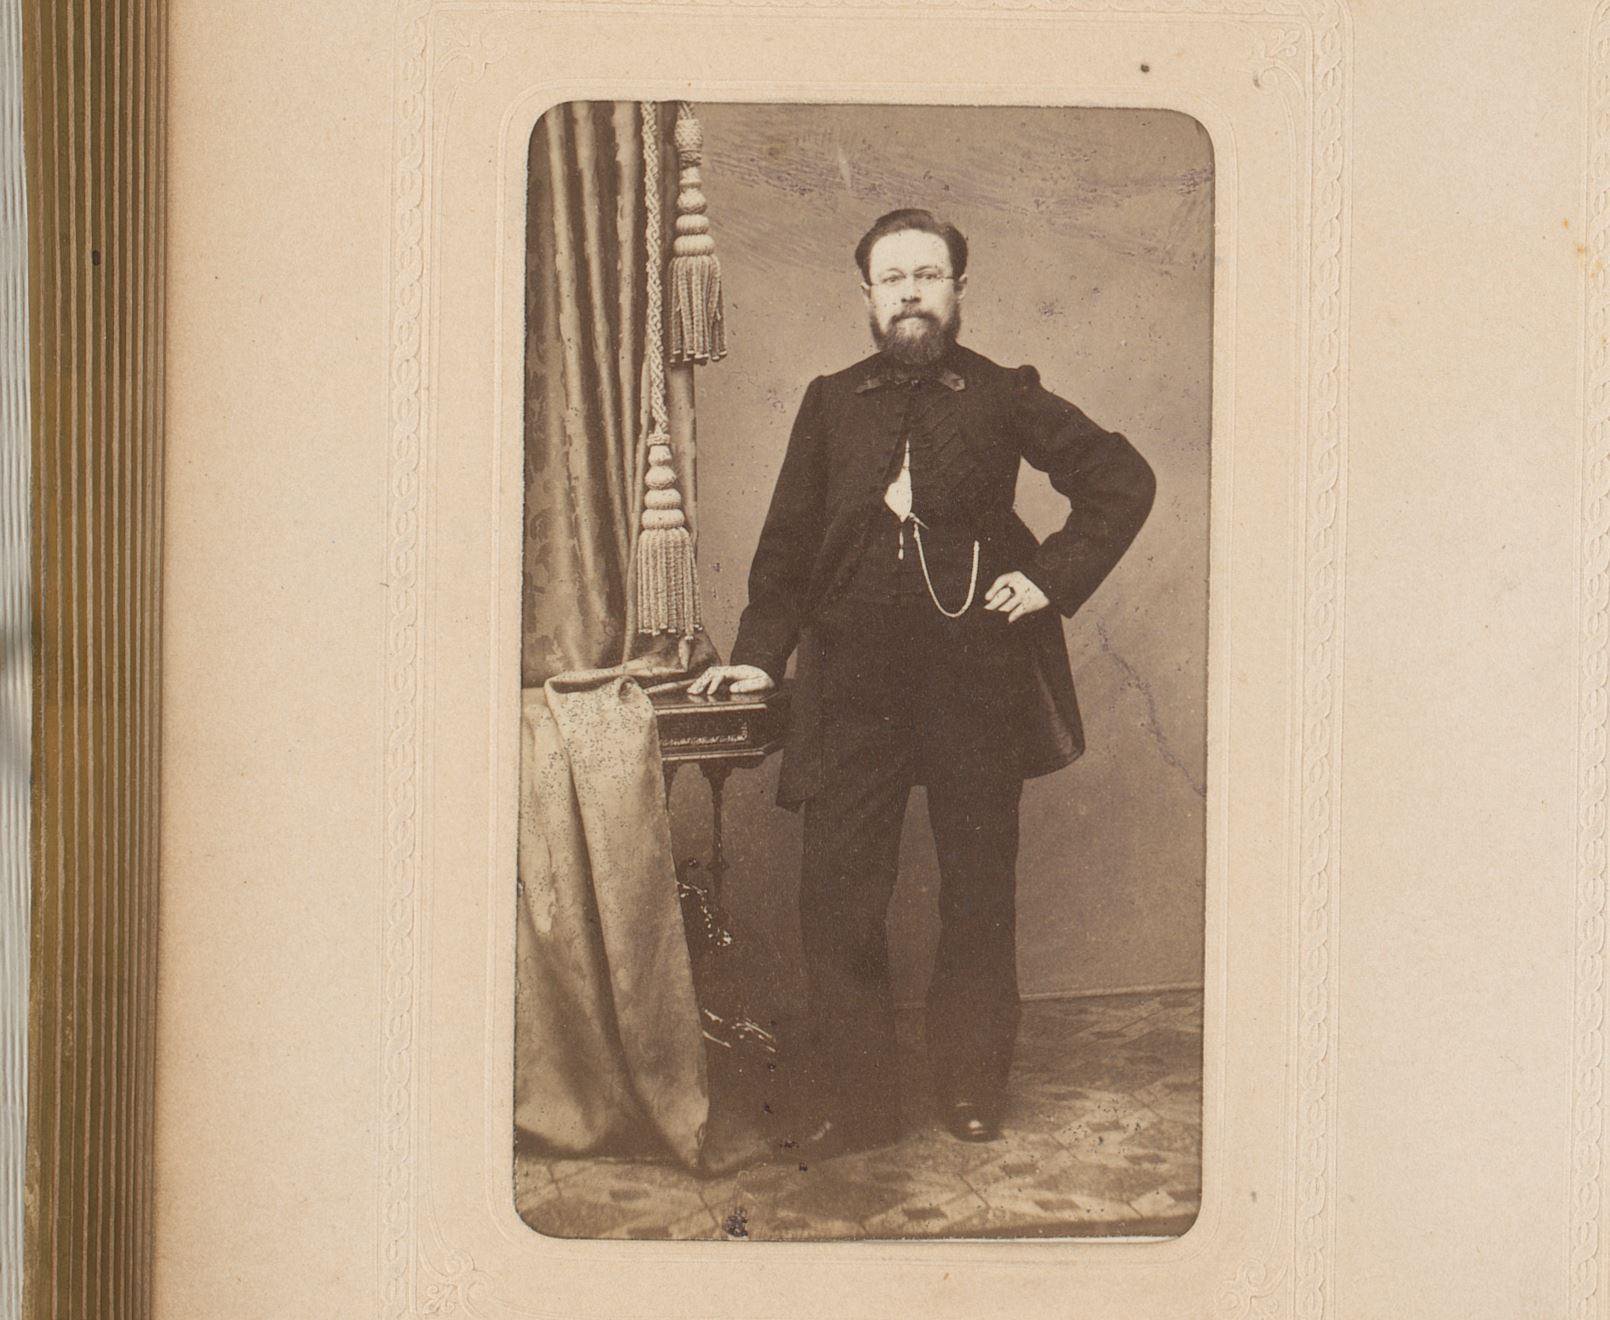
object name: photograph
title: Portret van een man met zakhorloge, staand bij een tafel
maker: johann brandeis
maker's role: painter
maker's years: 1813-1872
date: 1850-1872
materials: cardboard, photographic support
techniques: albumen print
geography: prague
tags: standing figure, historical persons, table, watch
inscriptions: inscription: ‘FOTOGRAFIE/ MALIRE J. BRANDEISA/ V PRAZE/ 1271/u Naporti nada [..]’